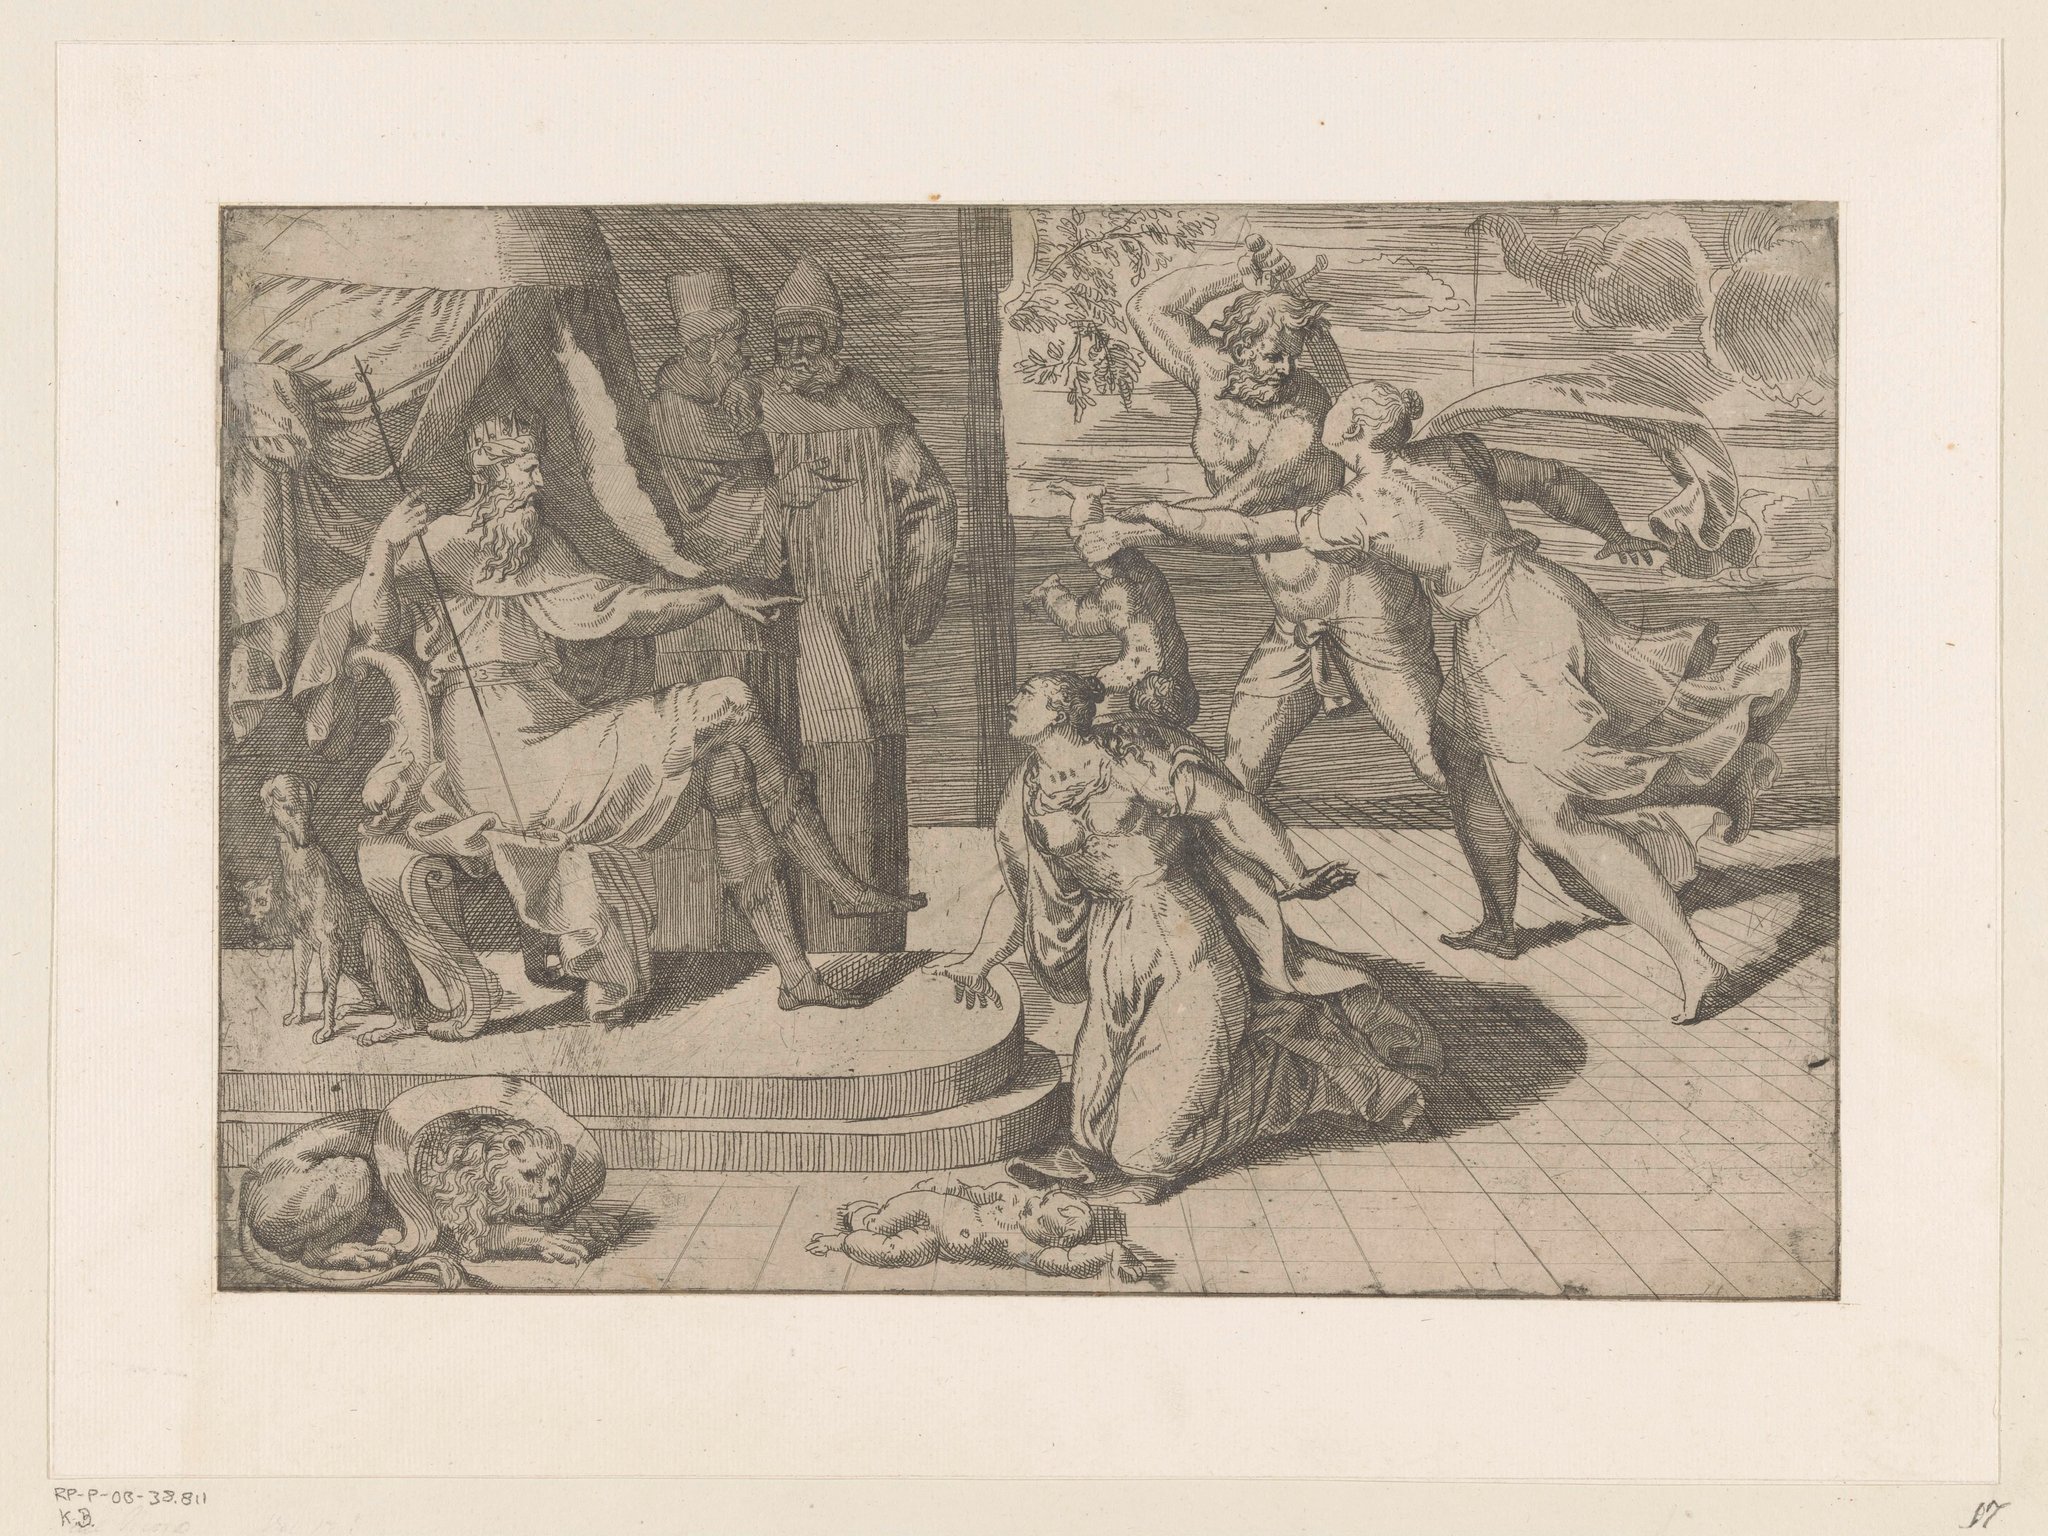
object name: print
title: Oordeel van Salomo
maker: Anonymous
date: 1500-1599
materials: paper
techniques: etching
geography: italy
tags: the judgement of solomon (1 kings 3:16-28)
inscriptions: collector's mark: Lugt 240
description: Koning Salomo zit op zijn troon. Voor hem de twee vrouwen die allebei aanspraak maken op hetzelfde kind. De eerste vrouw knielt smekend neer voor Salomo. Naast haar ligt het dode kind. Een soldaat met een zwaard houdt het levende kind vast aan een been, terwijl de tweede vrouw zijn arm vastgrijpt. Links op de voorgrond ligt een leeuw.